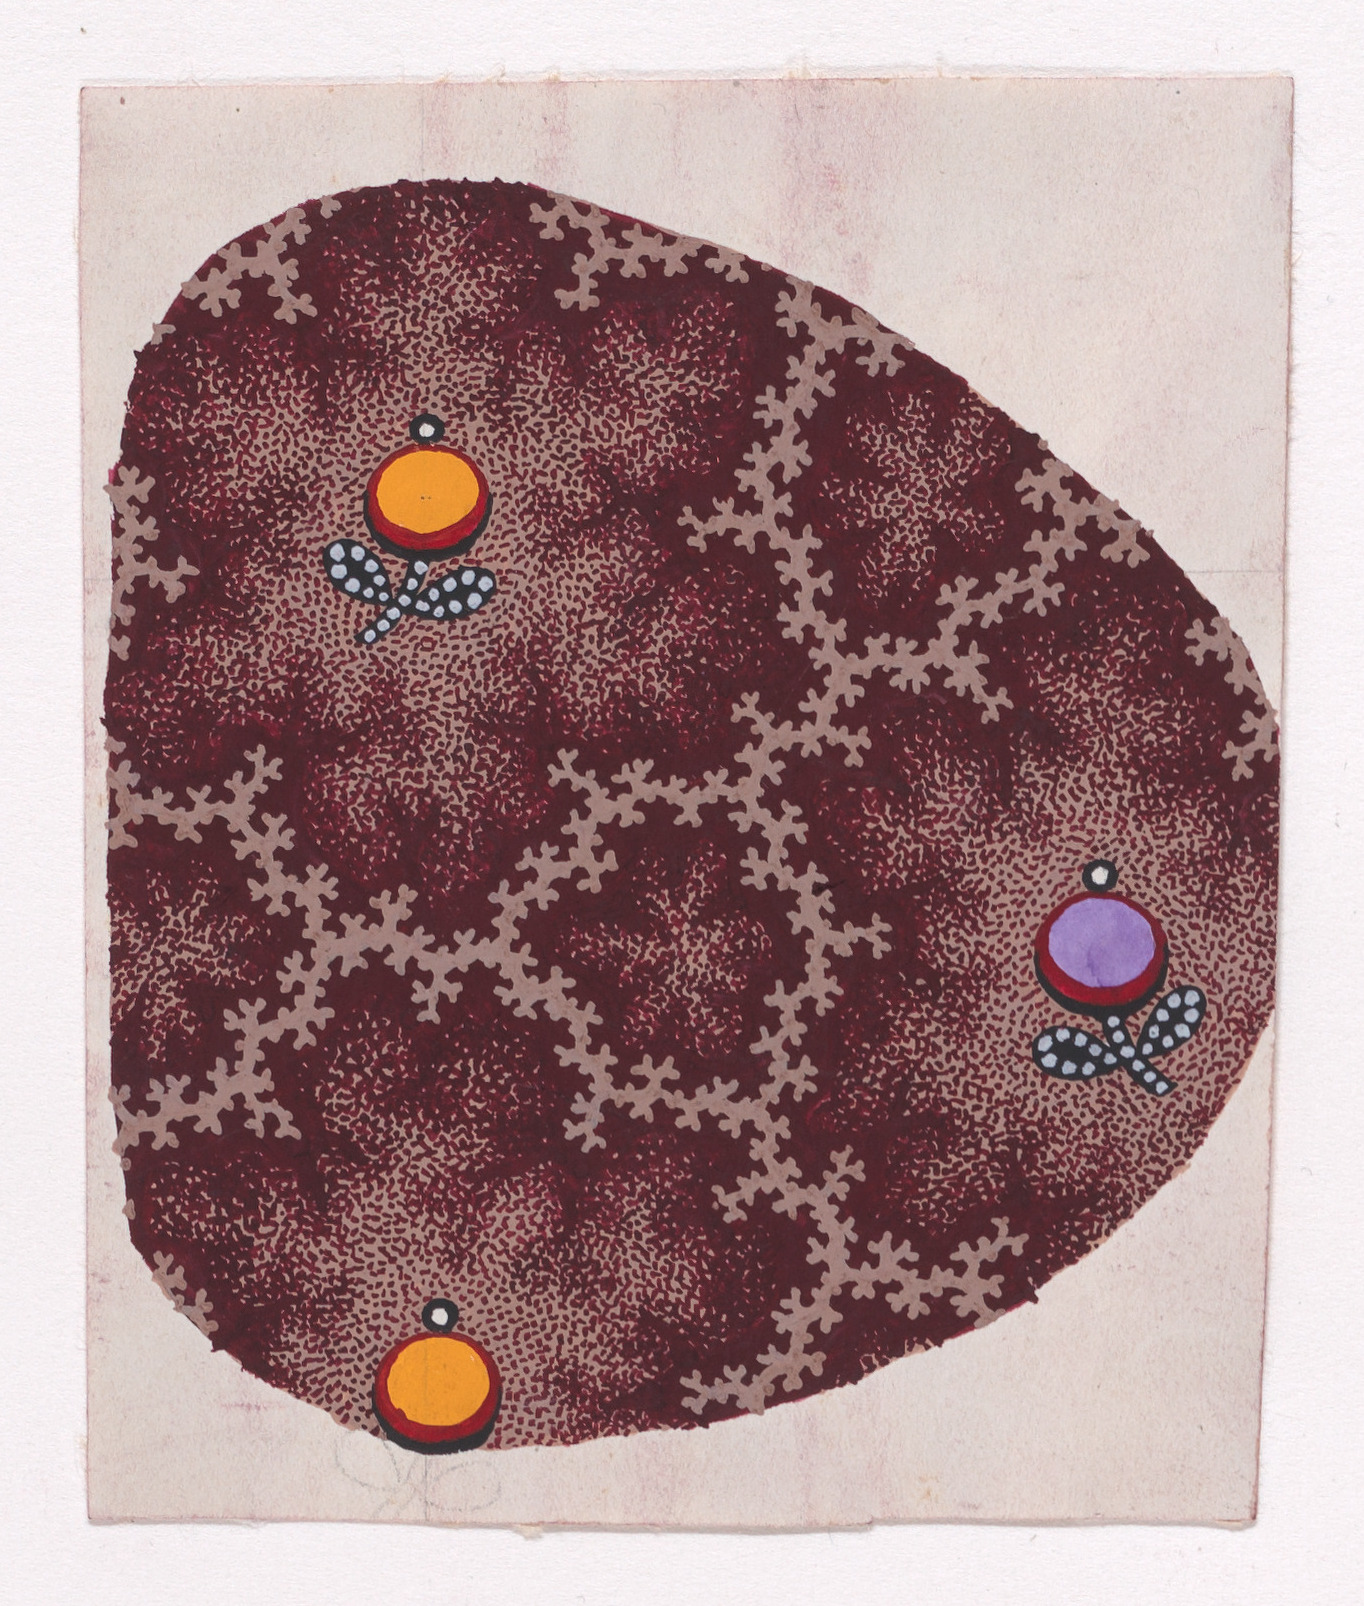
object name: drawing ornament architecture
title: Textile Design with Alternating Rows of Circular Flower Buds on Stems with Two Leaves and Decorated by Pearls Framed with Garlands of Branches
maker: anonymous, alsatian, 19th century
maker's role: artist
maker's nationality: alsatian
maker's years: 1800-1900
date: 1840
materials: gouache